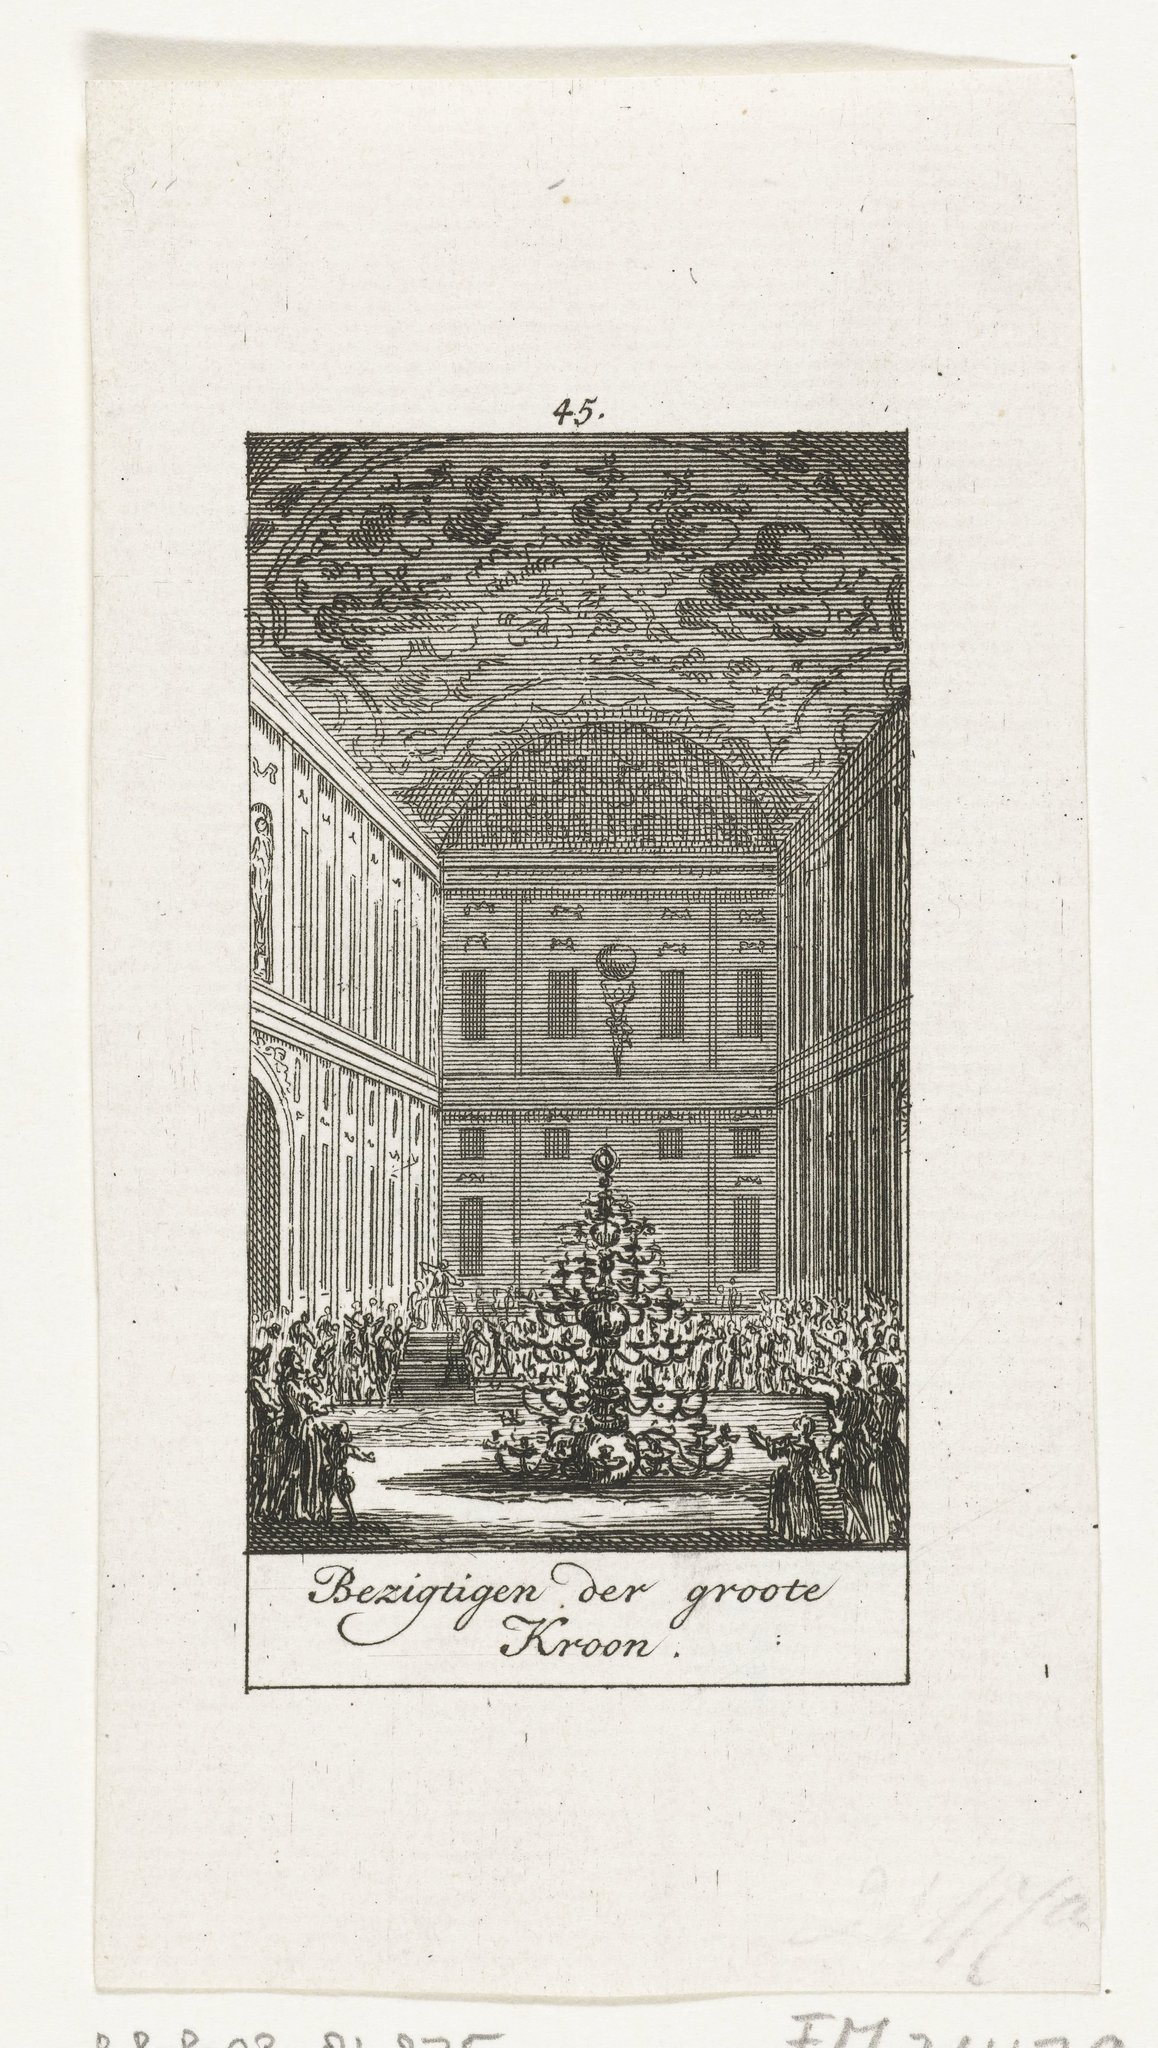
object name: history print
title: Bezichtiging van de grote kroonluchter, geschenk aan de Russische tsaar, 1659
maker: simon fokke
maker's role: draughtsman, print maker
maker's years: 1712-1784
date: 1779-1781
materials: paper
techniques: etching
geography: netherlands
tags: chandelier, candelabrum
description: Gebruikt als illustratie in: Jacobus Kok, Amsteldamsche jaarboeken, behelzende de merkwaardigste geschiedenissen, welken, zo binnen de stad als daaromtrent, zijn voorgevallen, sedert haare eerste beginselen, tot op den tegenwoordigen tijd ... / Bijeengebragt door Jacobus Kok, 3 dln., J.B. Elwe, Amsterdam 1781.